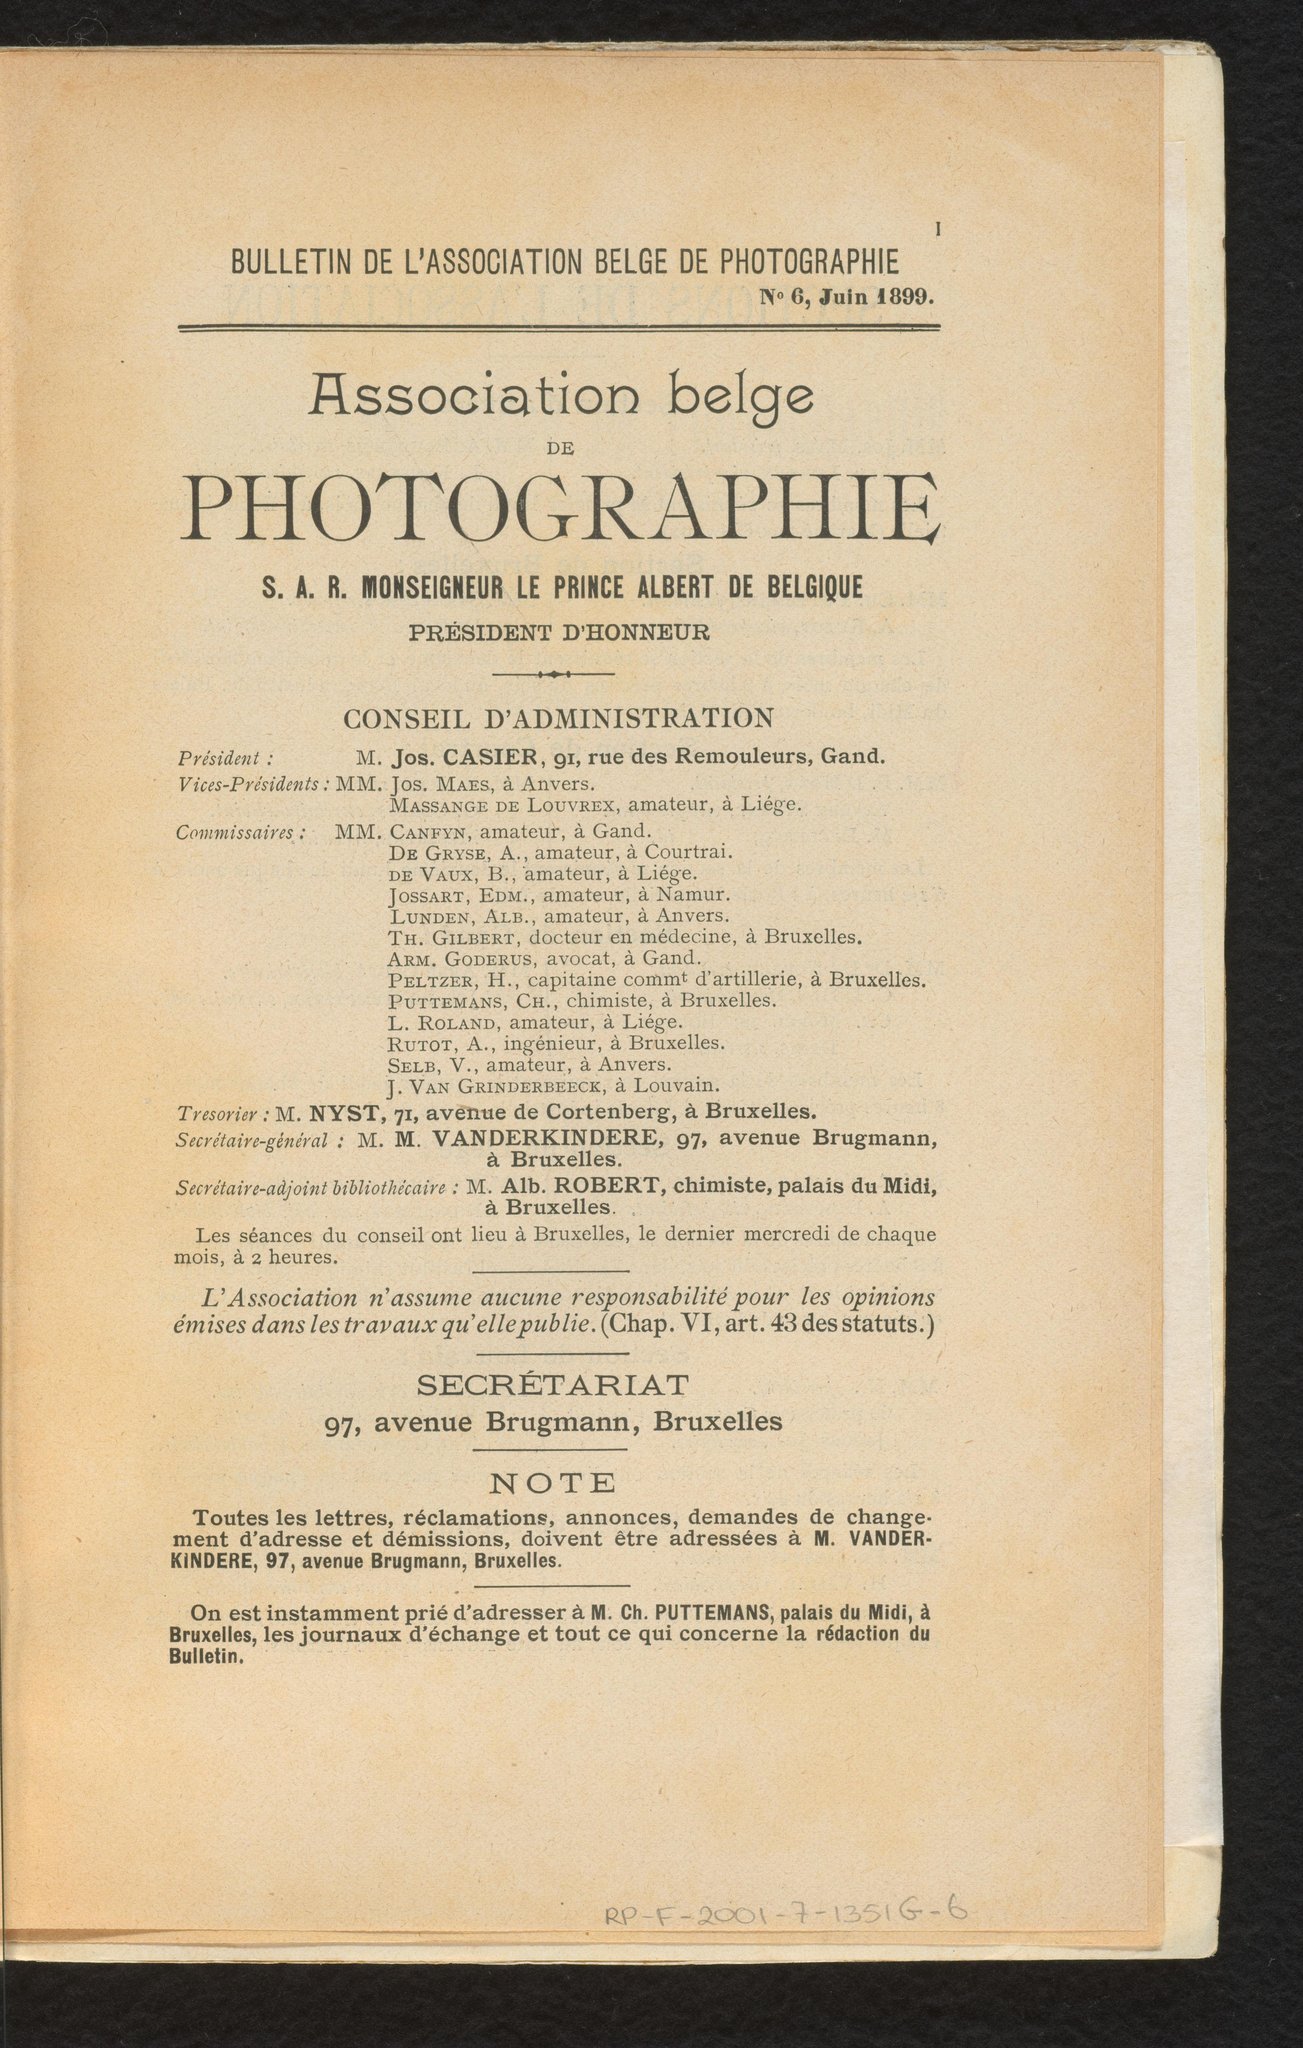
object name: book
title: Bulletin / Association belge de photographie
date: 1806-1899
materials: paper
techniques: printing, engraving